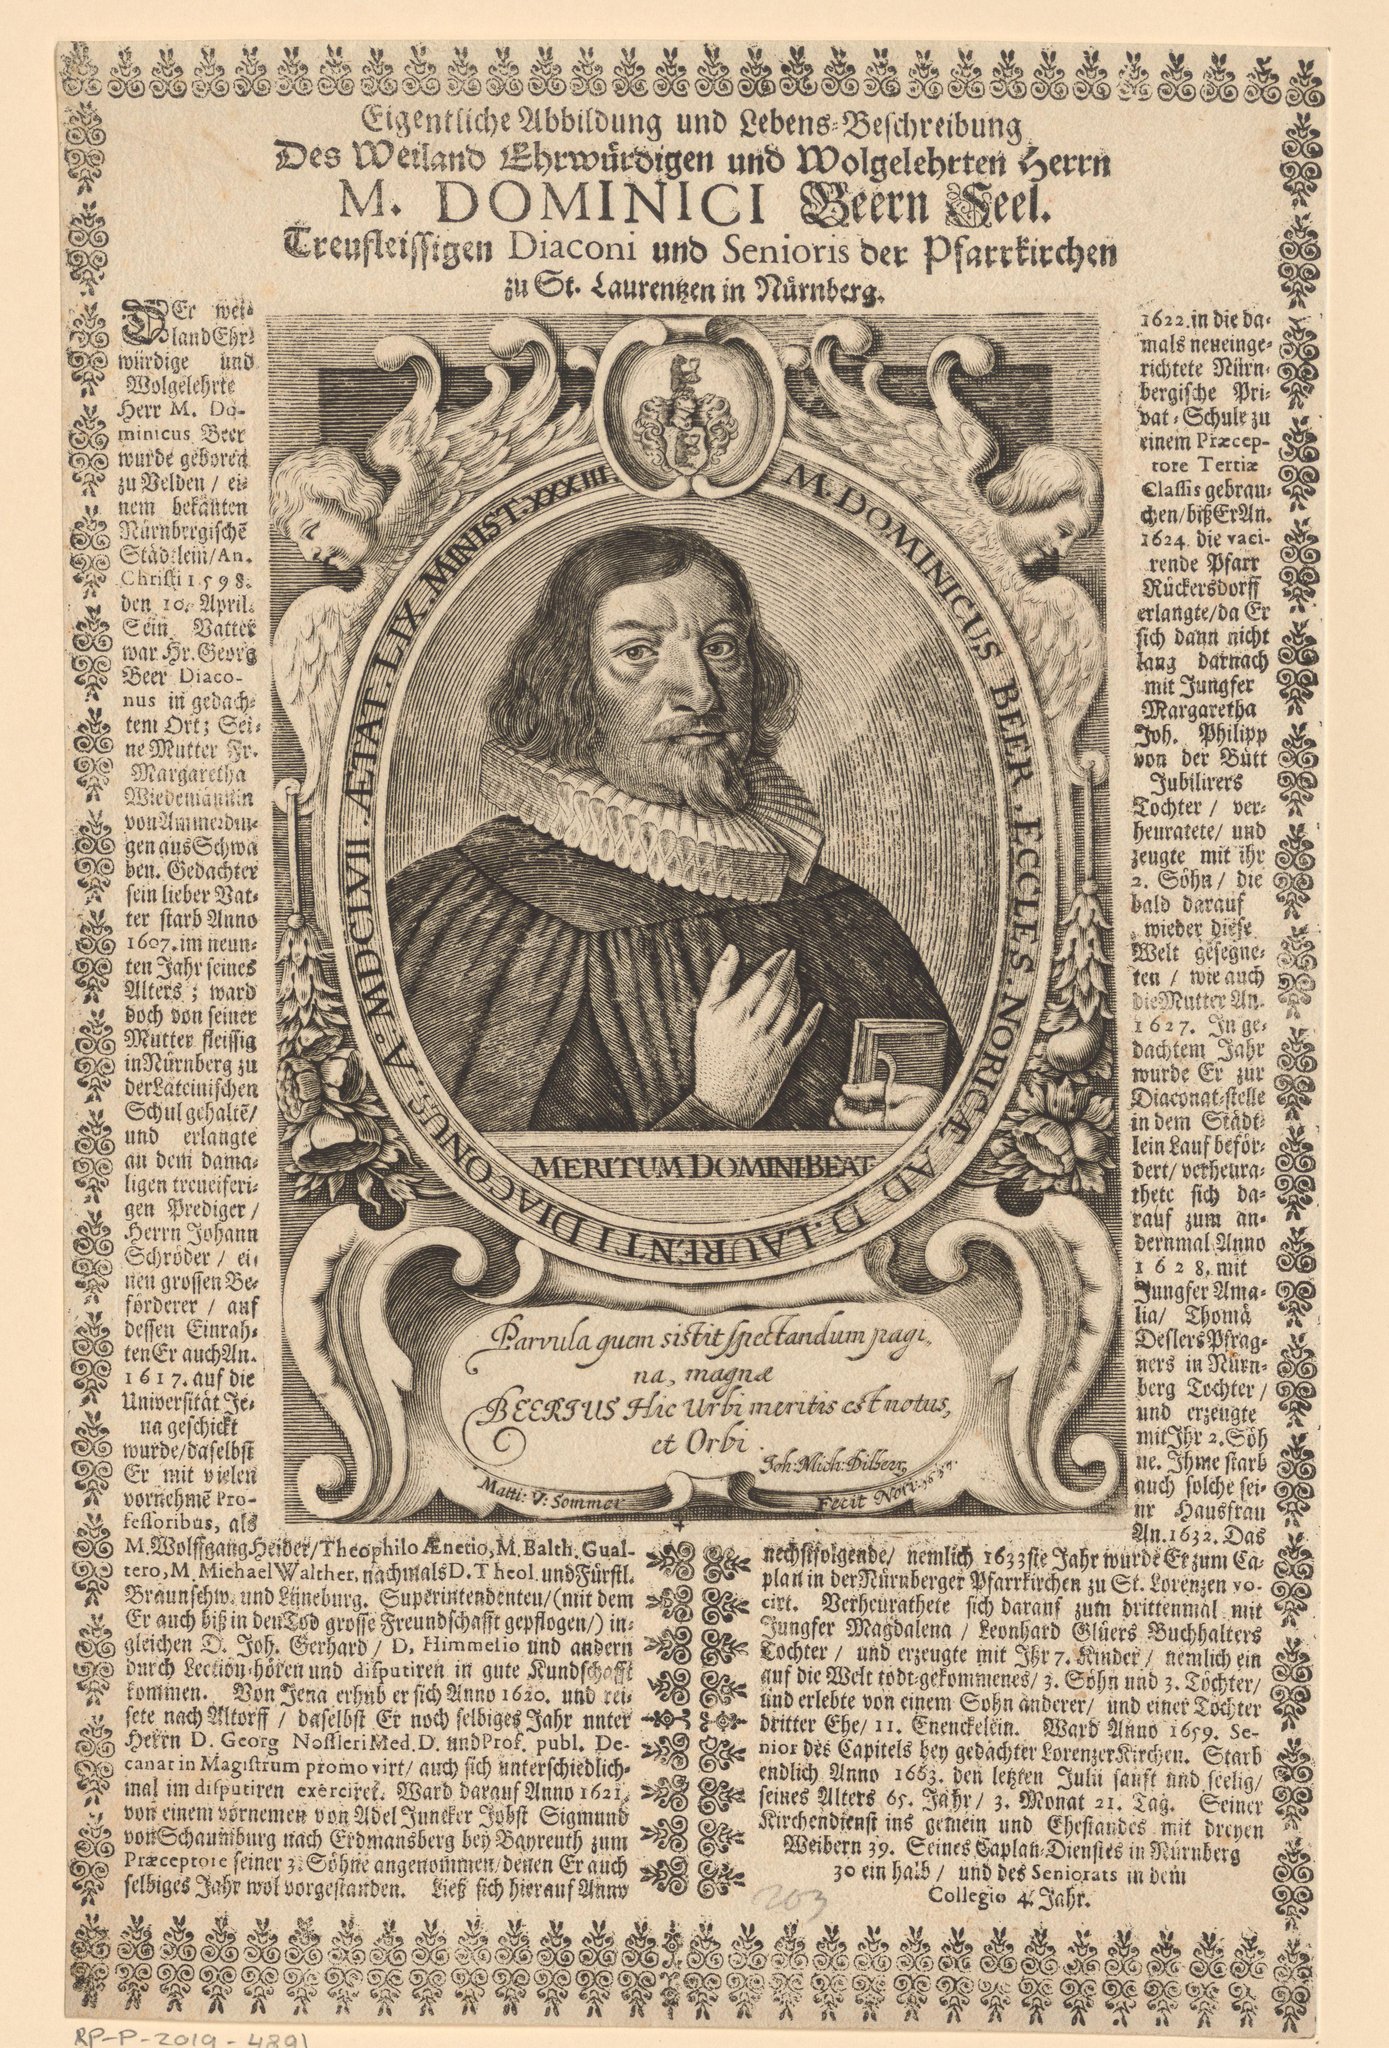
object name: print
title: Portret van Dominicus Beer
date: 1657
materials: paper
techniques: engraving, letterpress printing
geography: nuremberg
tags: historical persons, angels, armorial bearing, heraldry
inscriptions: date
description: Met midden boven het portret zijn wapenschild.